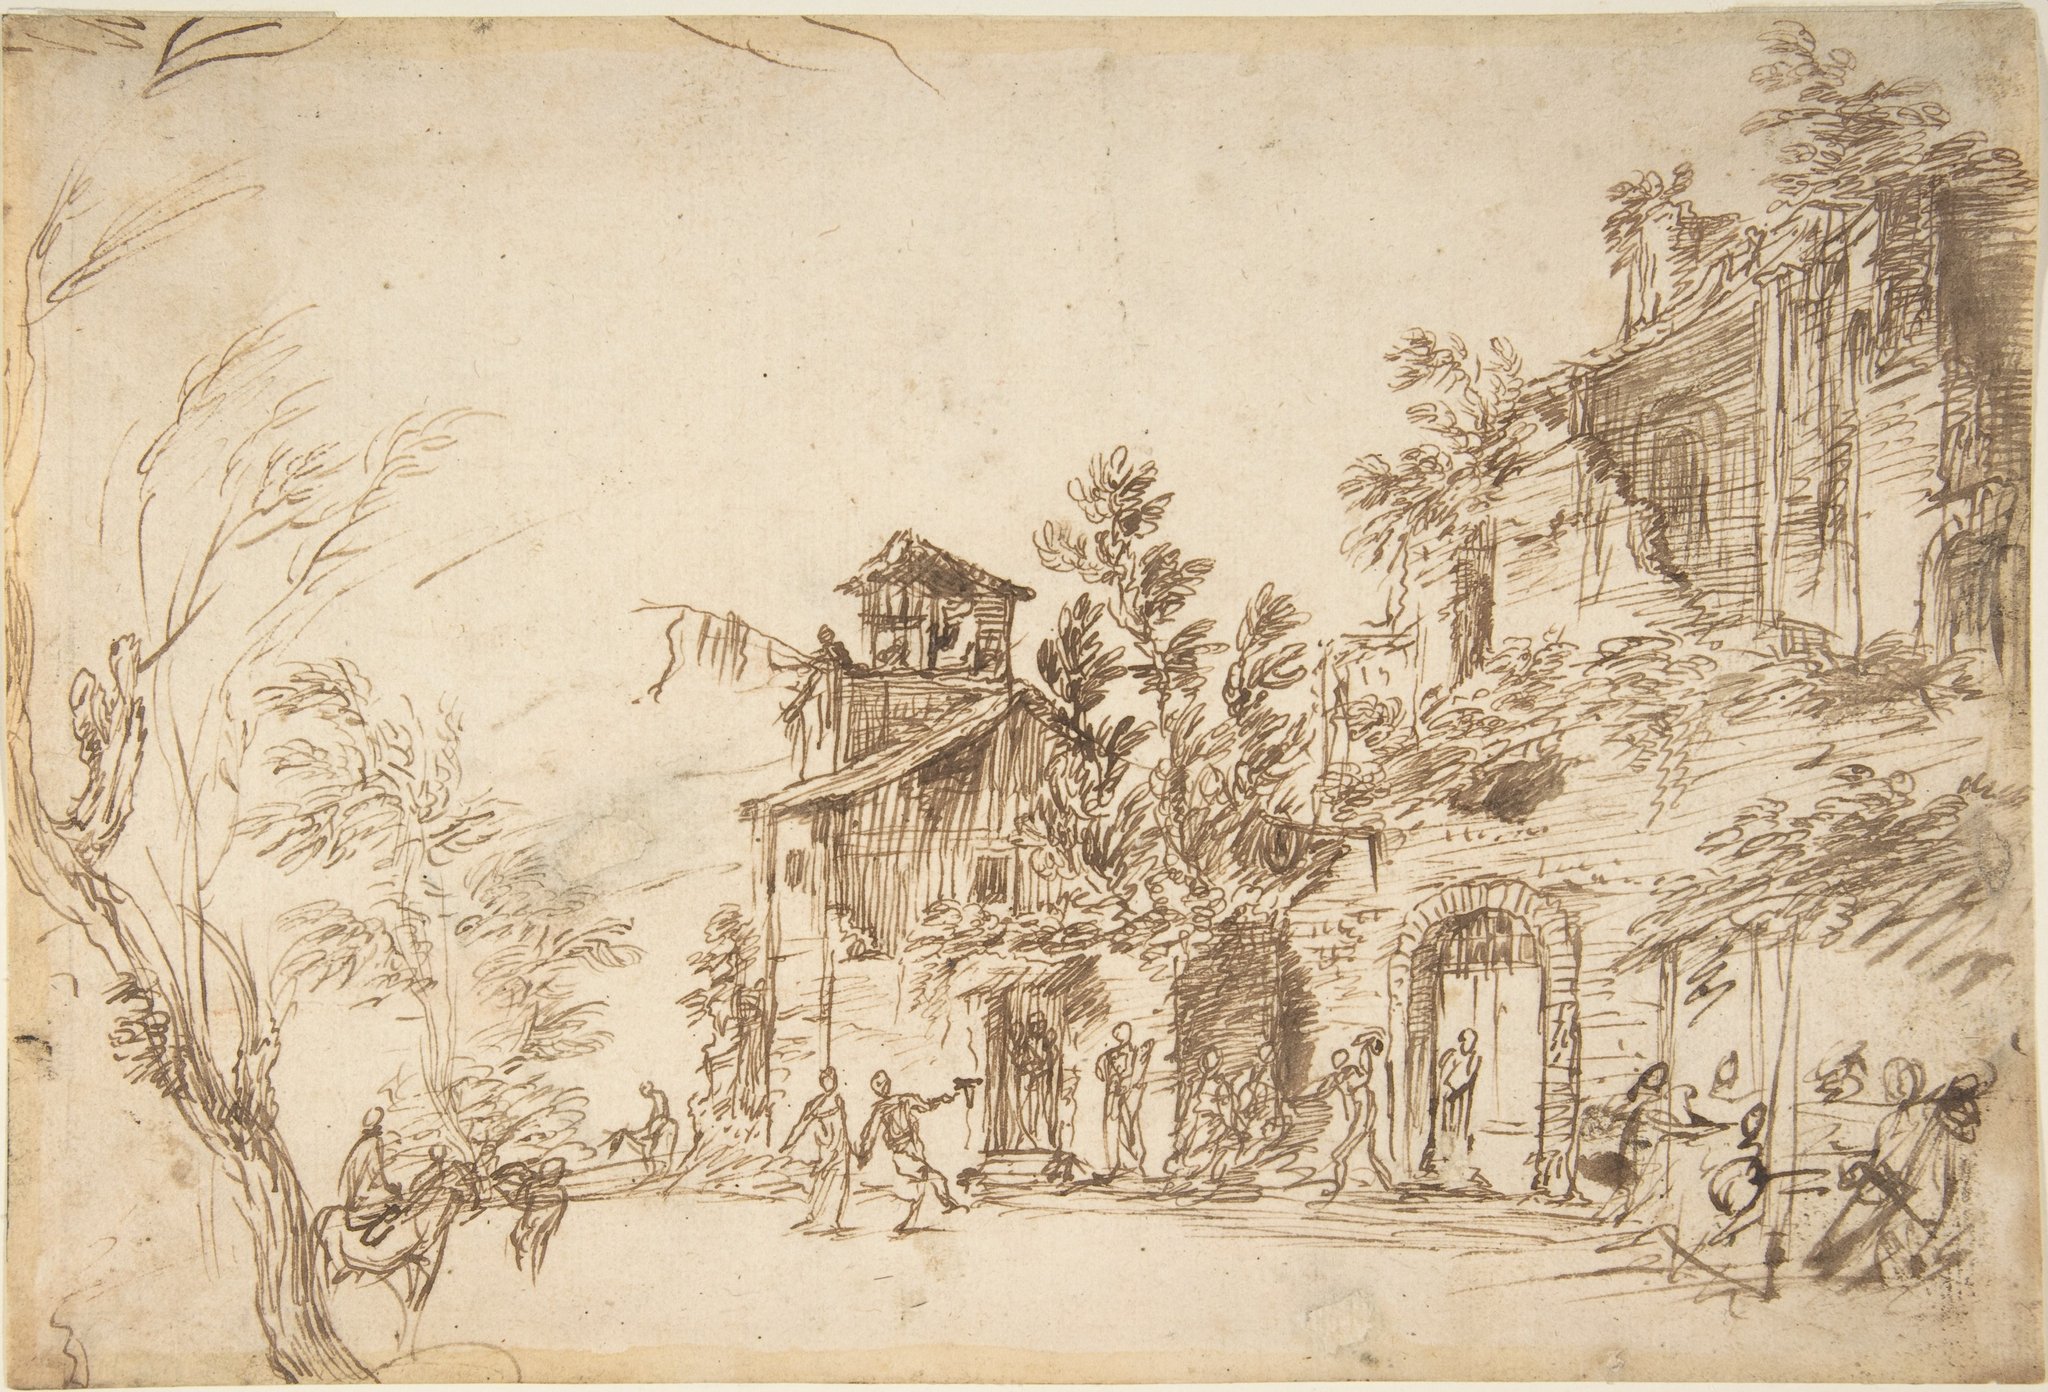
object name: drawing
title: Landscape with Ruins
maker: anonymous, italian, venetian, 18th century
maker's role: artist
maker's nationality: italian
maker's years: 1700-1800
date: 1701-1800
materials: ink, paper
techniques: pen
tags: human figures,ruins,landscapes,trees